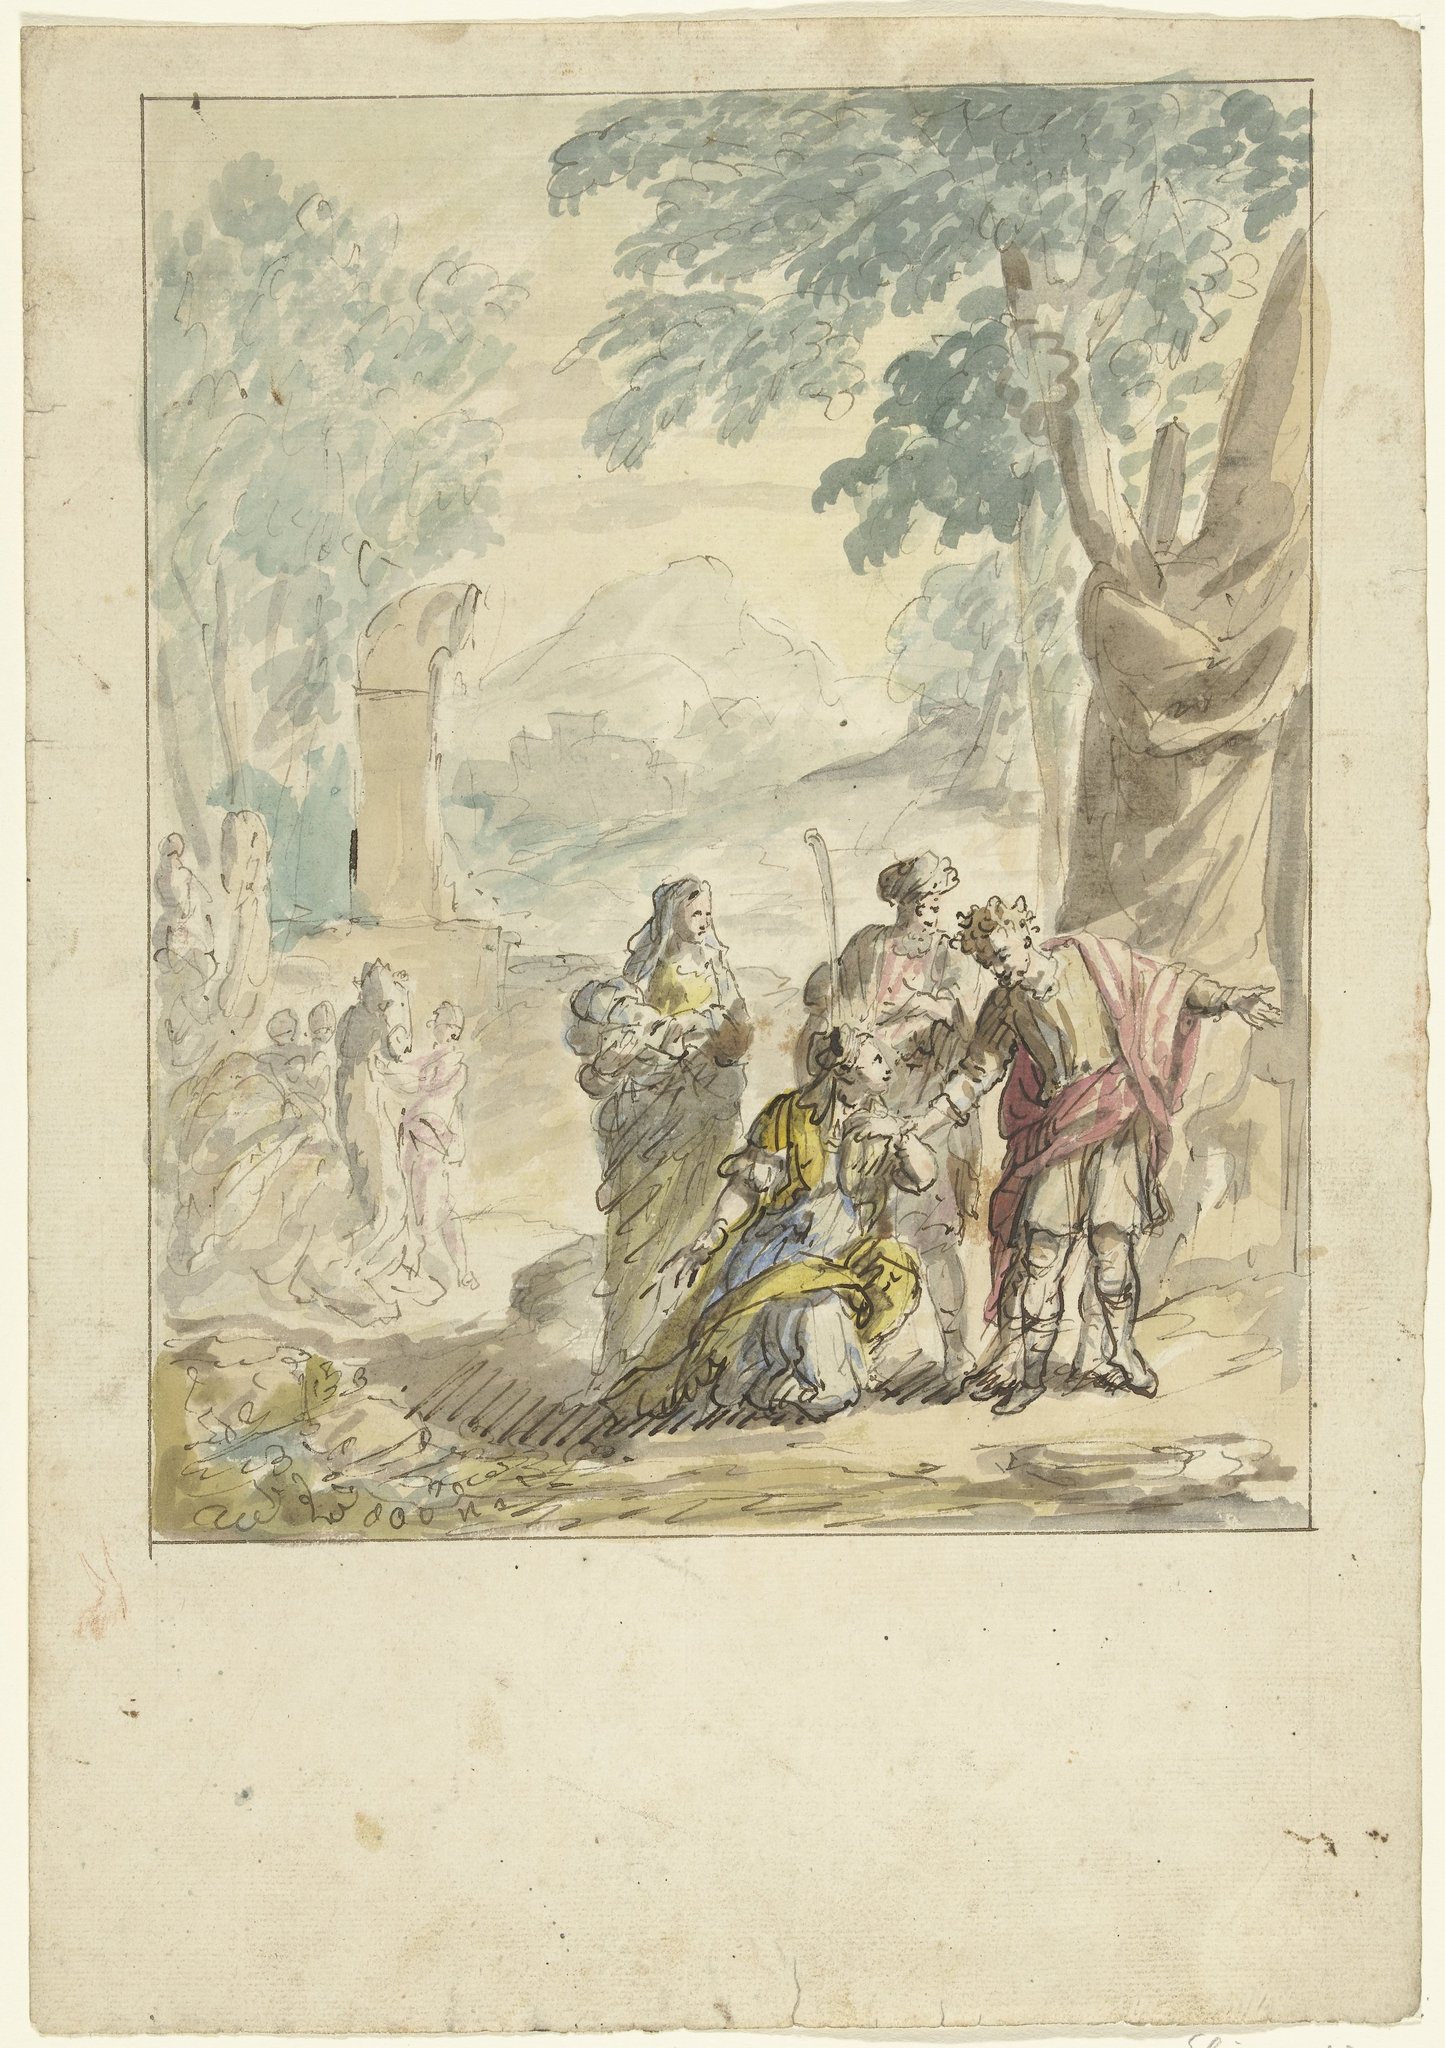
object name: watercolor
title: Izaäk ontvangt Rachel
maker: elias van nijmegen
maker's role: draughtsman, painter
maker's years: 1667-1755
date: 1677-1755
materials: ink, paper, pencil, watercolor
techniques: brush, pen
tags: isaac, walking in the fields, meets rebekah